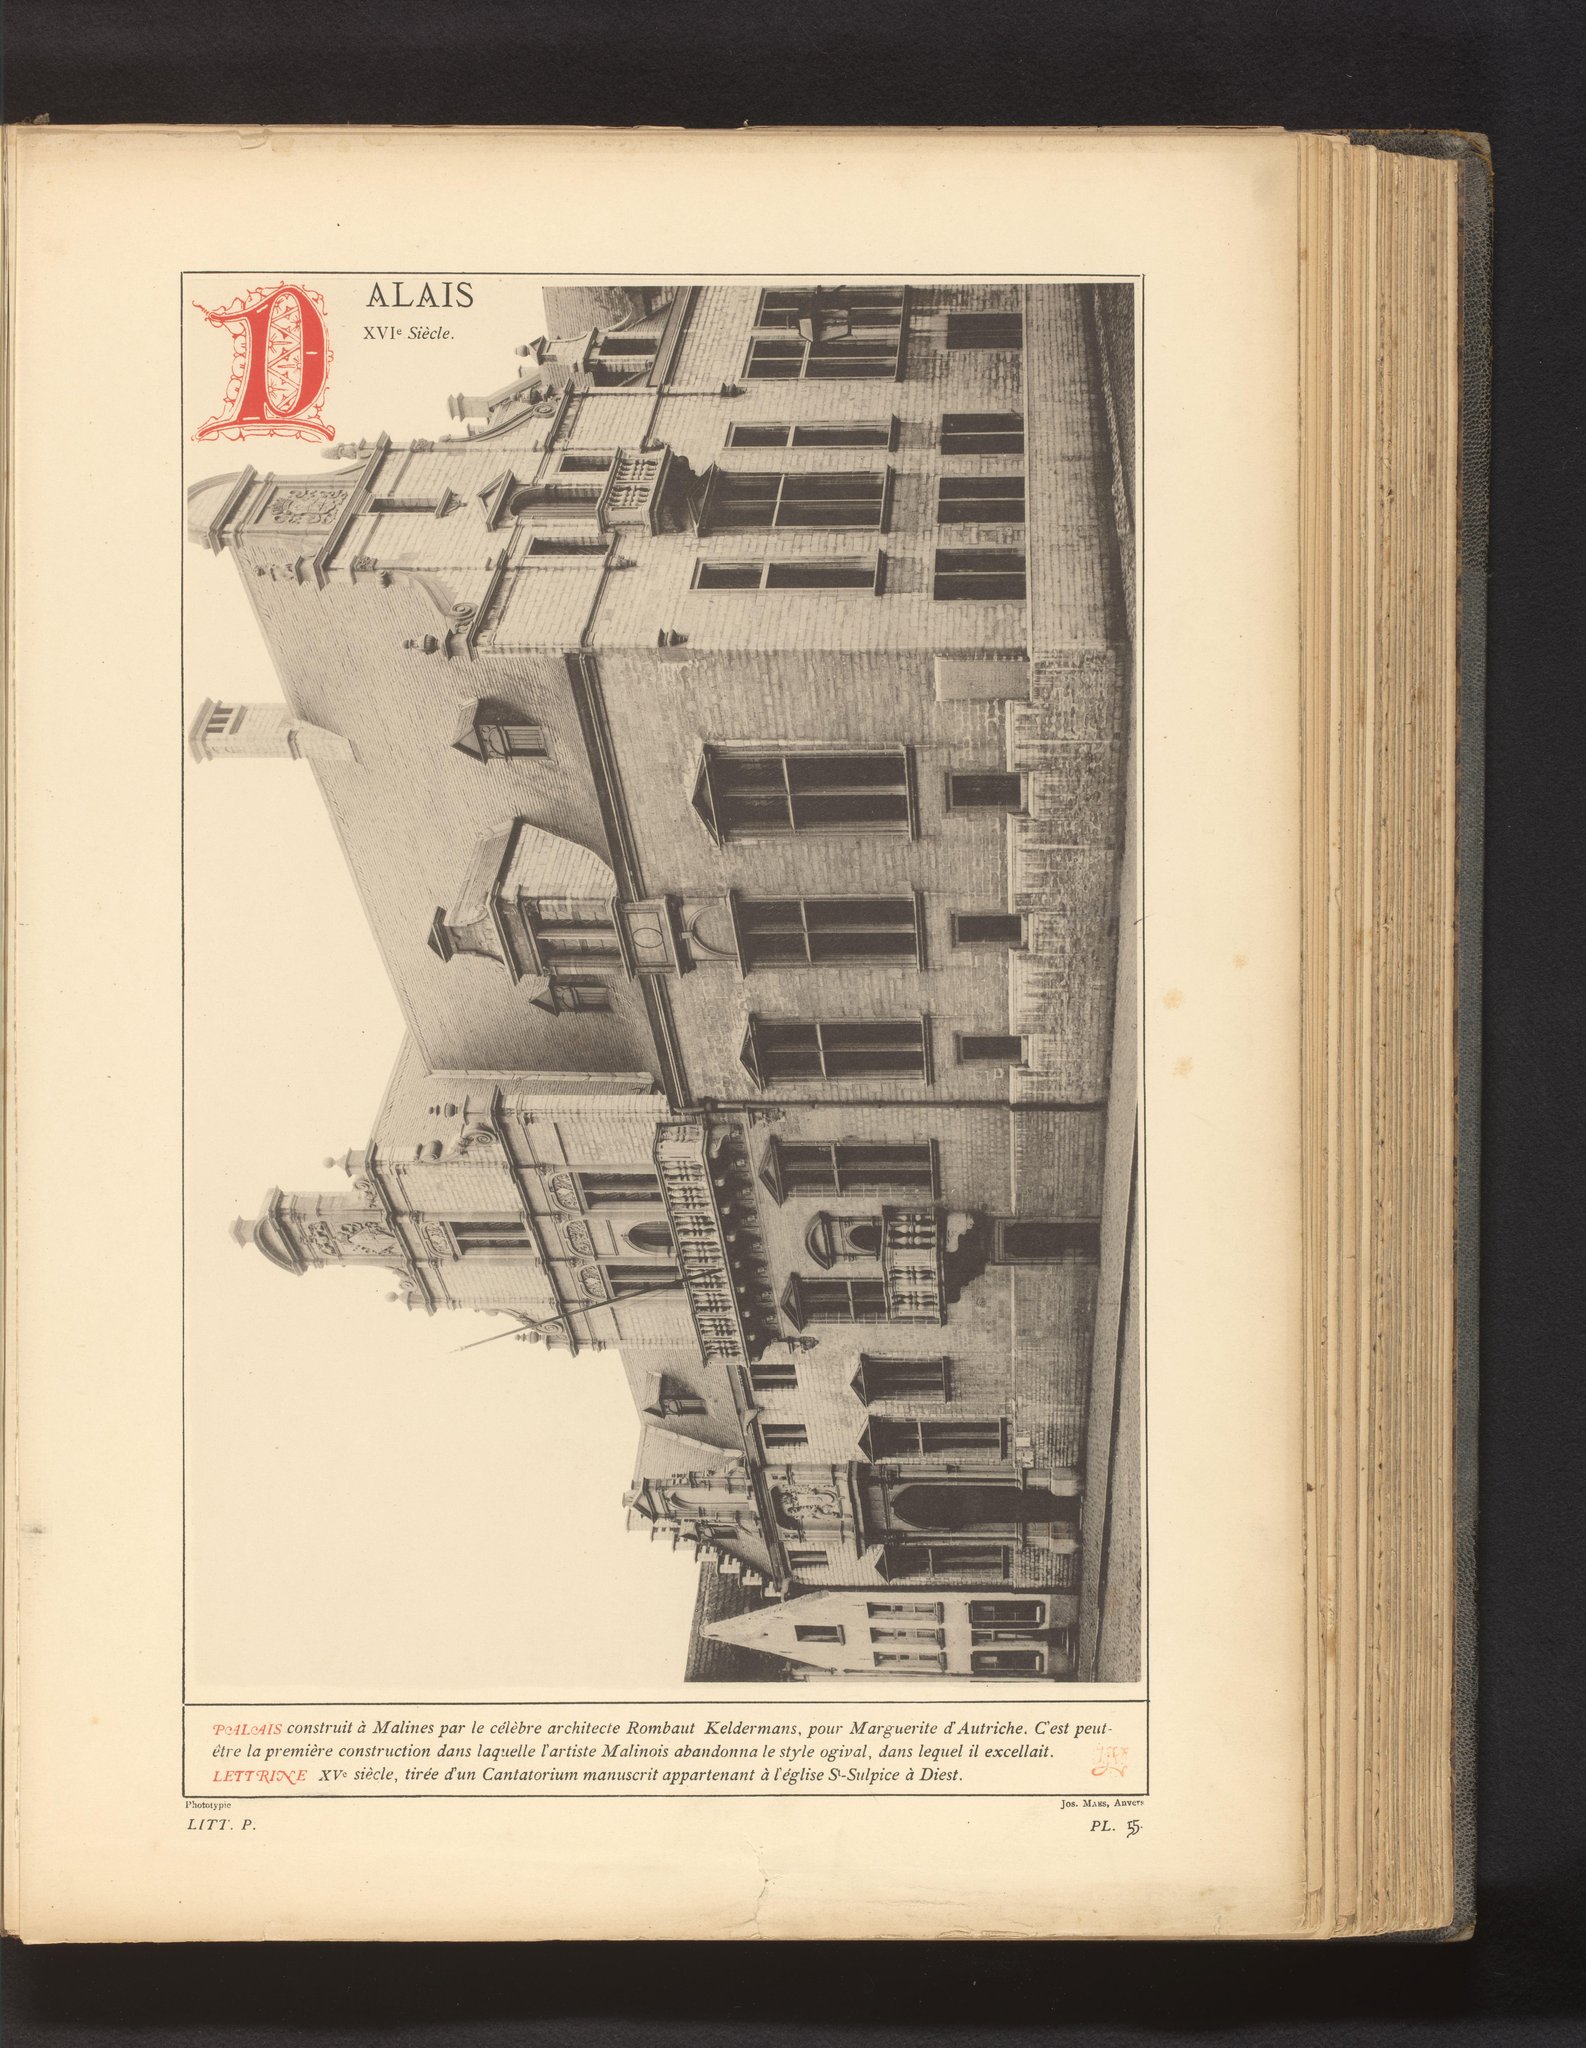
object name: photomechanical print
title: Hof van Savoye te Mechelen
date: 1876-1881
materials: paper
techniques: photograph, photolithography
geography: antwerp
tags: palace, mechelen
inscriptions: inscription: ‘LITT. P. - PL. 55.’, inscription: ‘PALAIS construit à (...)’, monogram: ‘JJvY’